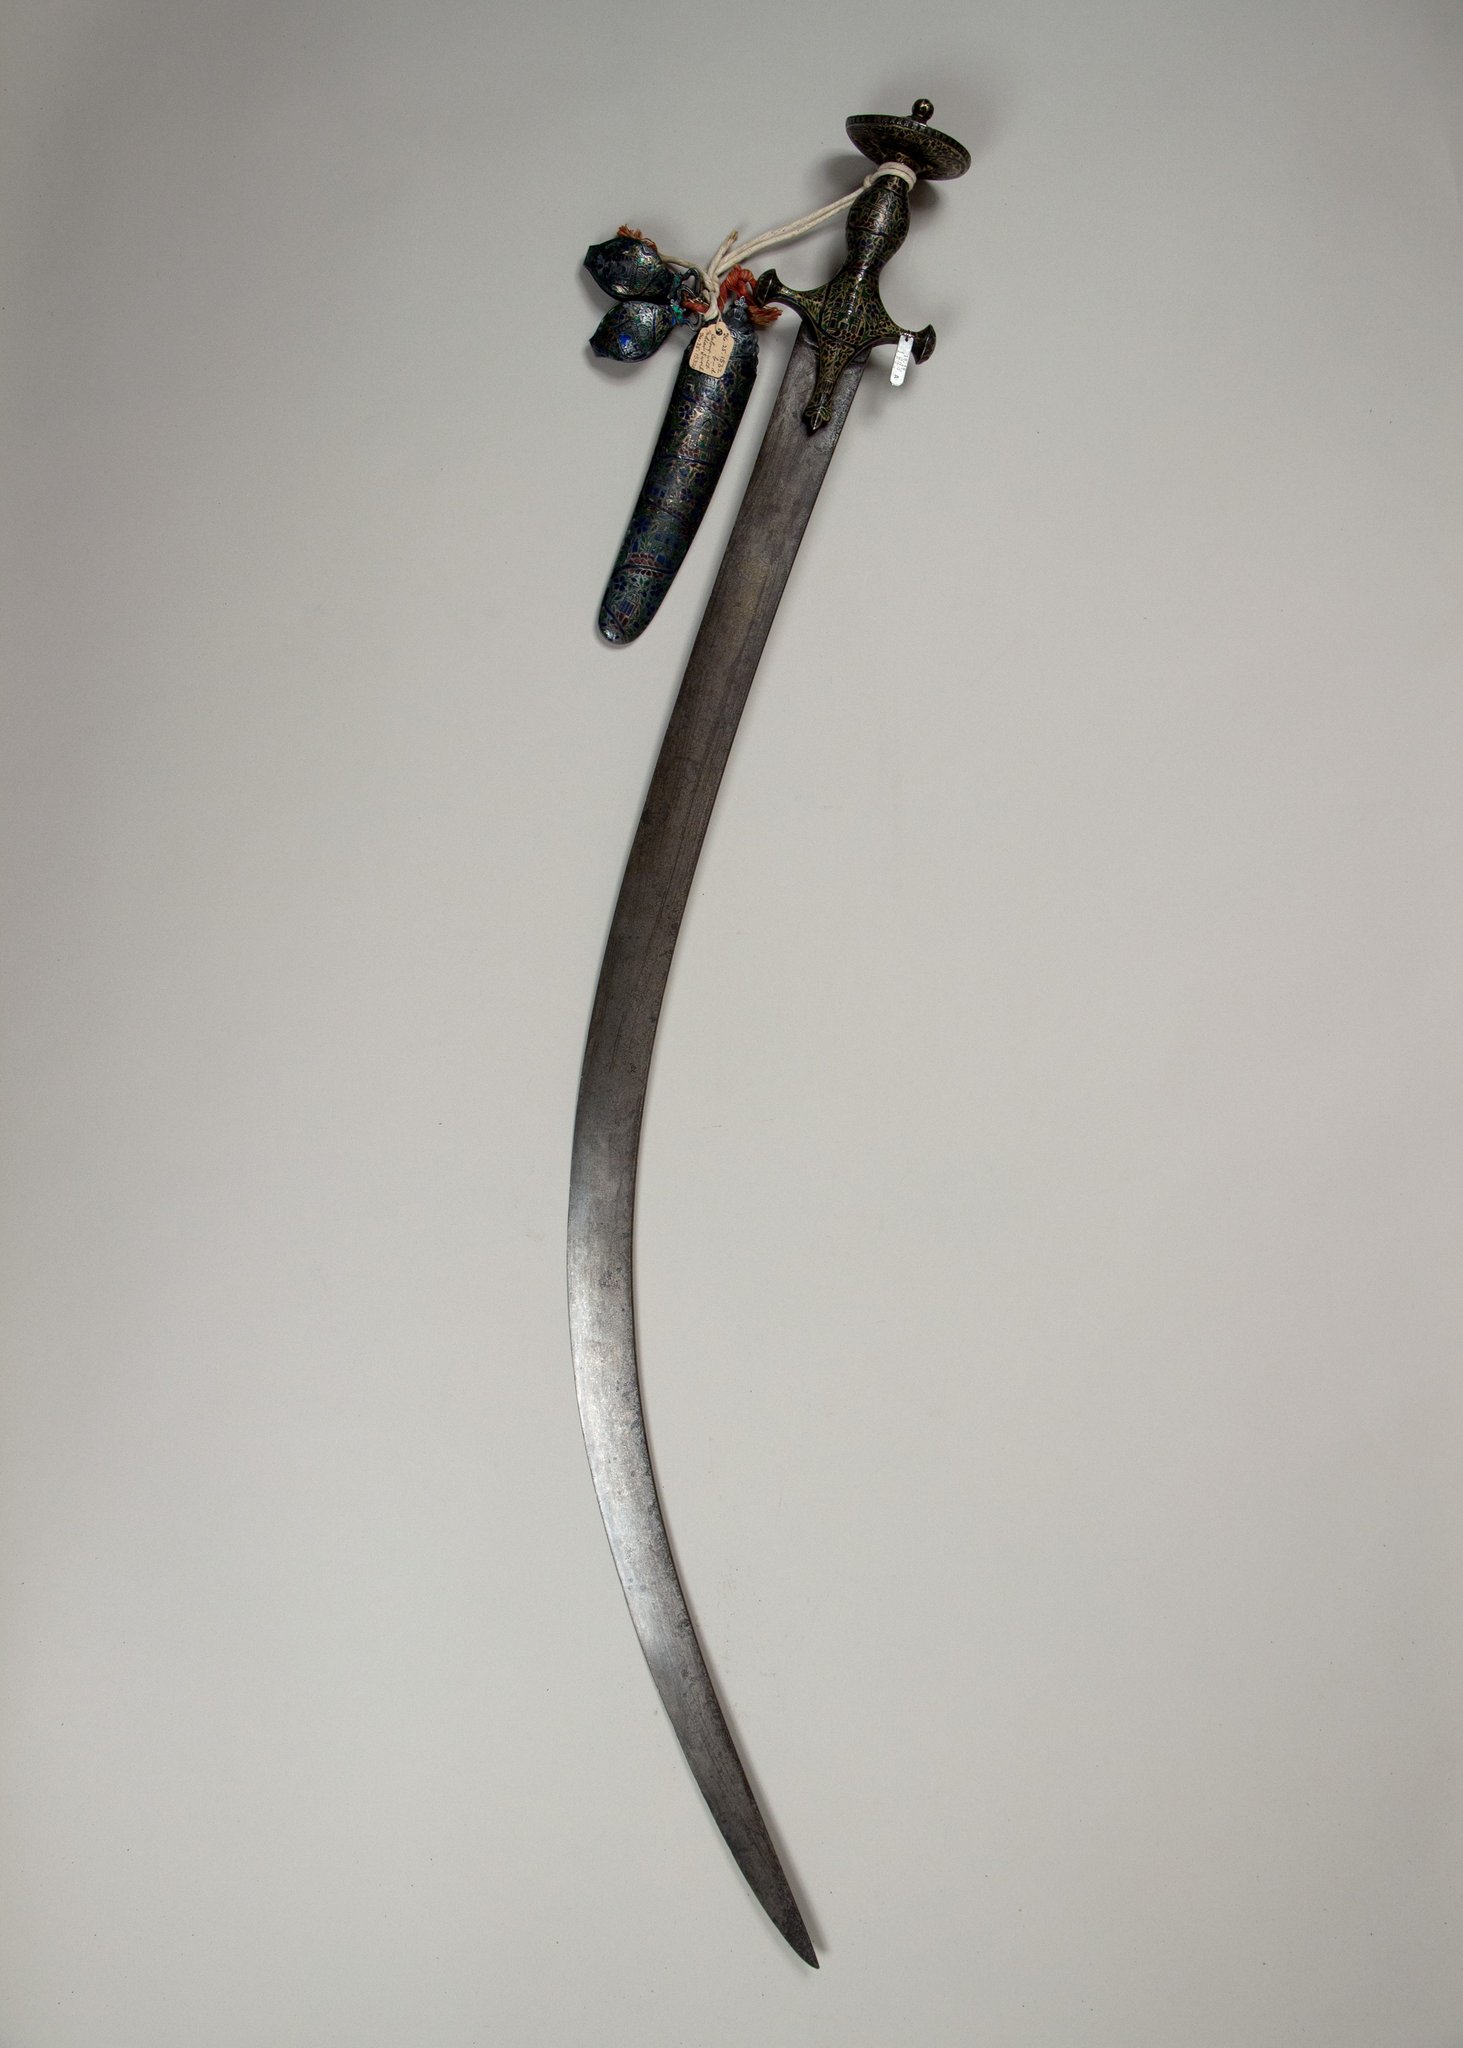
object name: sword shamshir with scabbard chape and sling strap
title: Sword (Shamshir) with Scabbard Chape and Sling Straps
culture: indian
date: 1801-1900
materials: enamel, gold, steel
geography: india